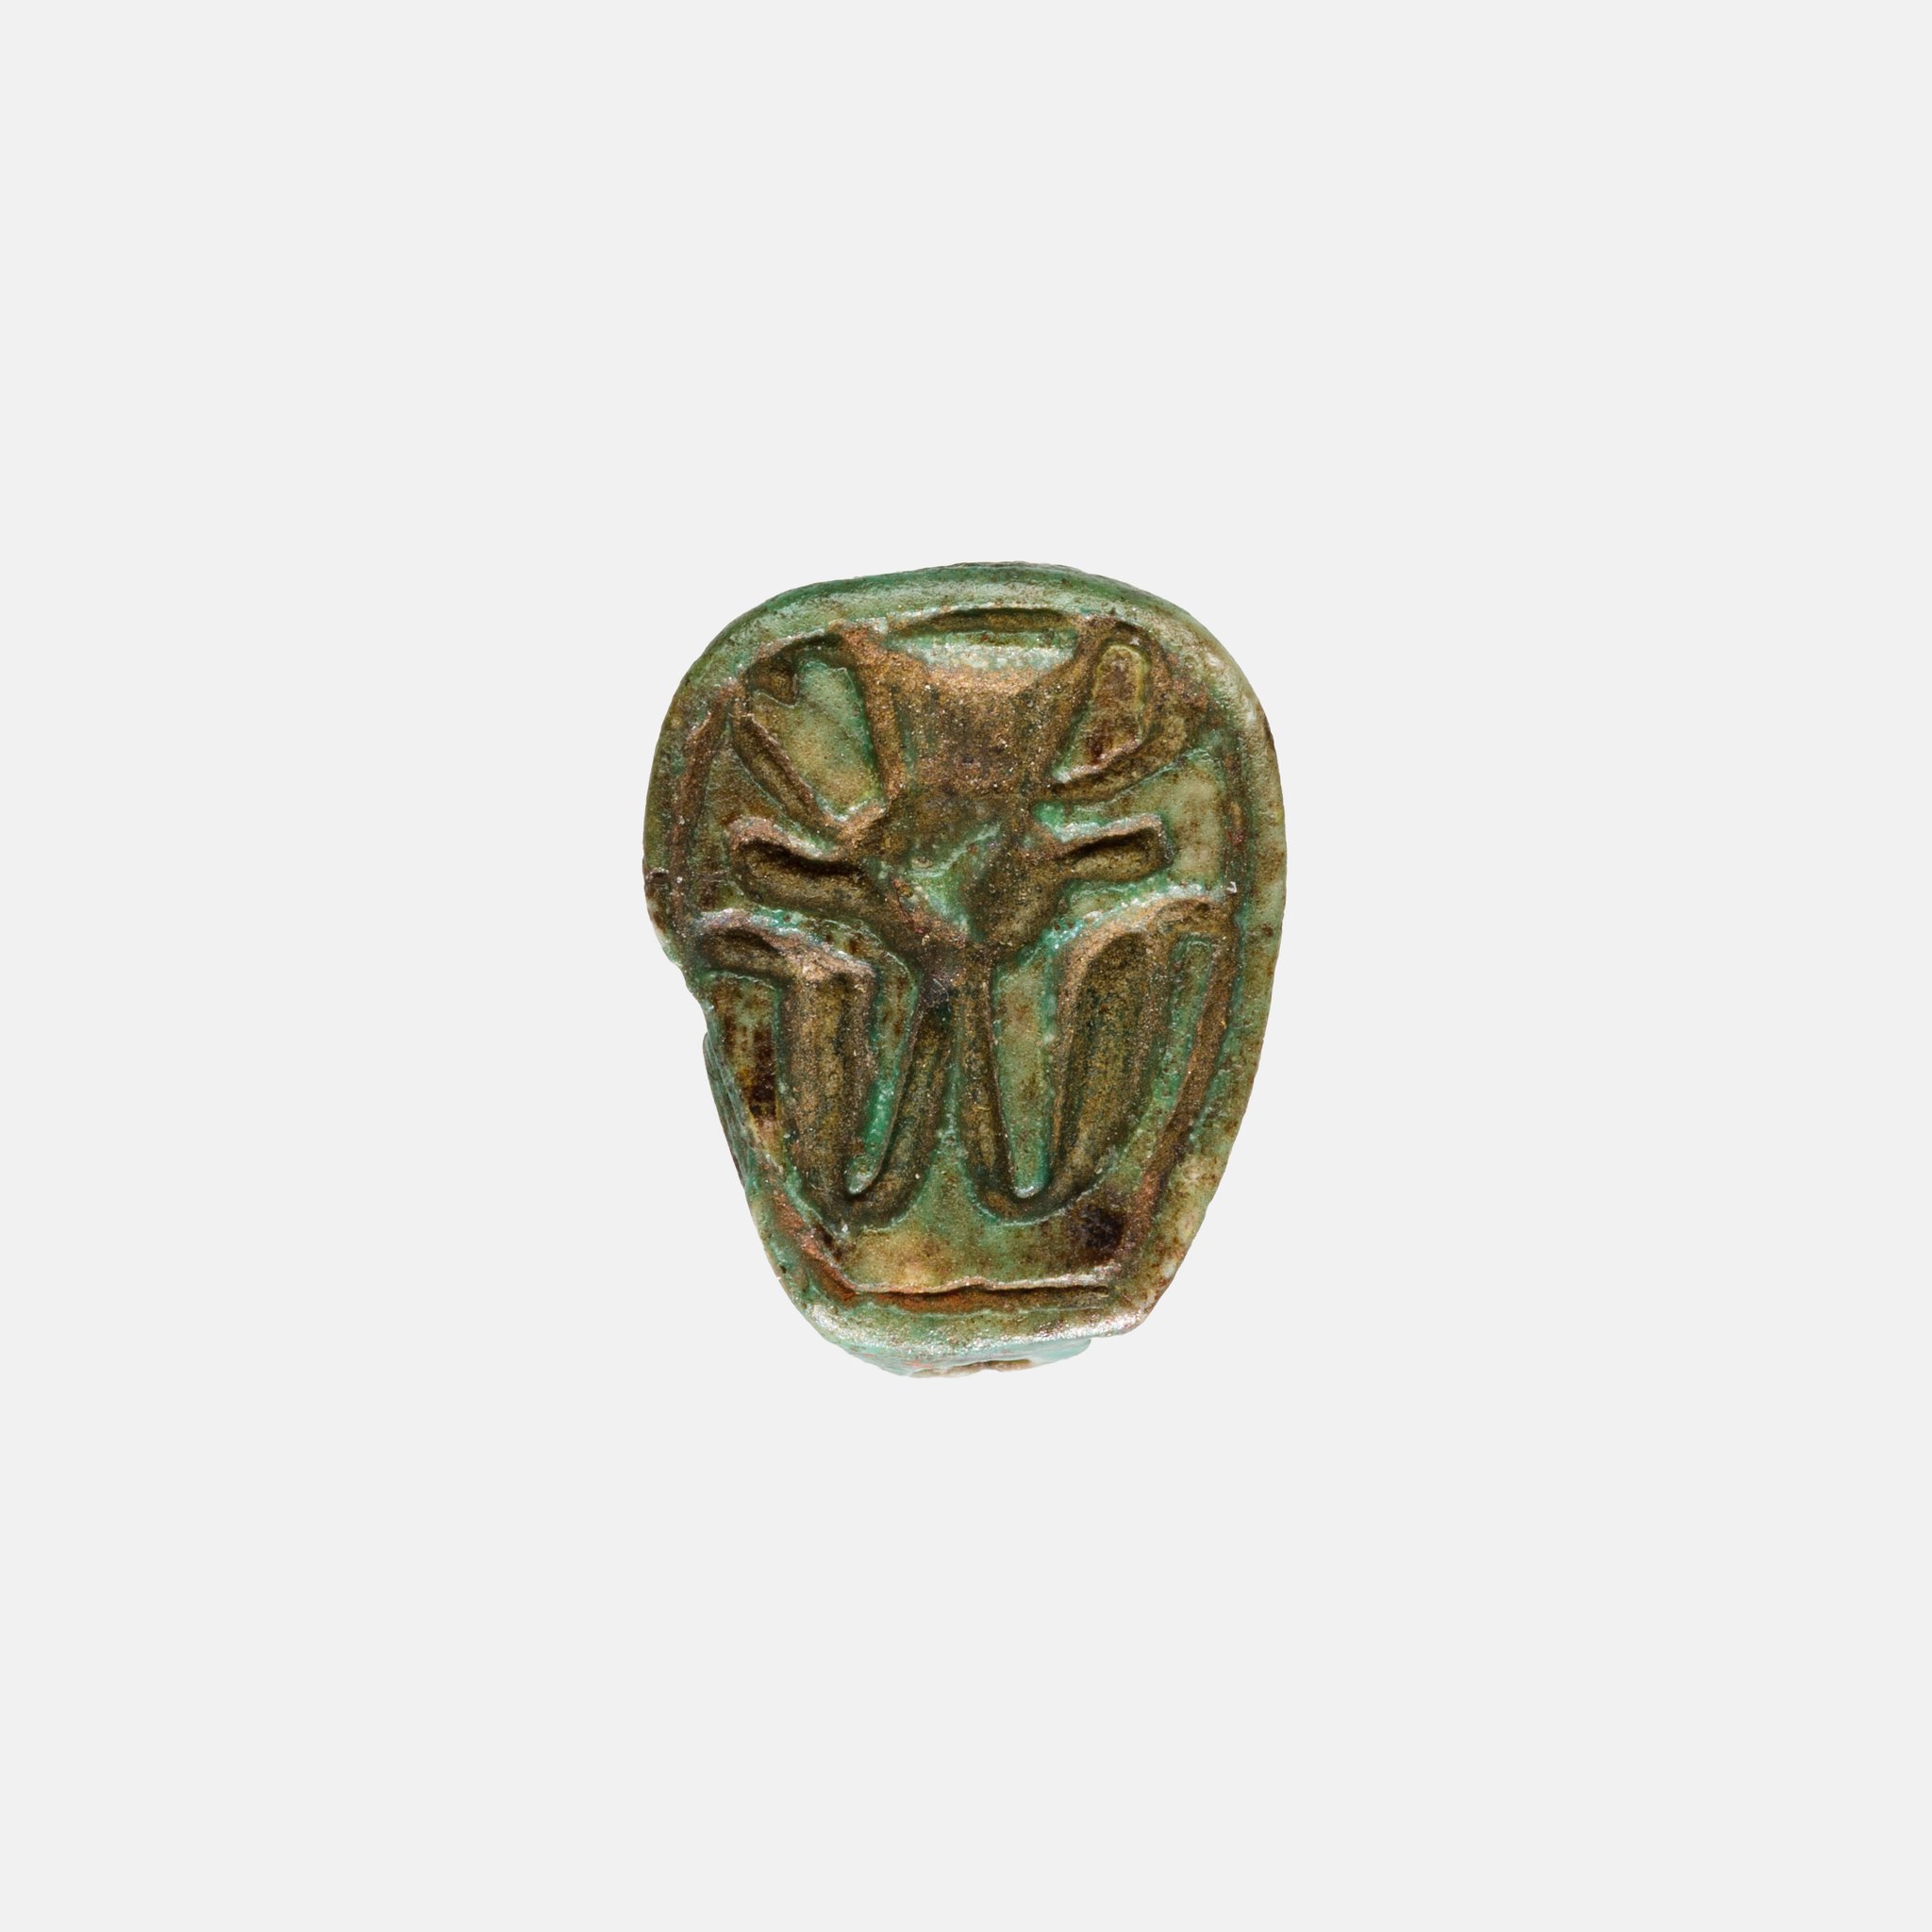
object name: stamp seal, duck, hathor emblem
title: Stamp Seal in the Shape of a Duck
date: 1550-1295 BCE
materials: faience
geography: egypt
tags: ducks